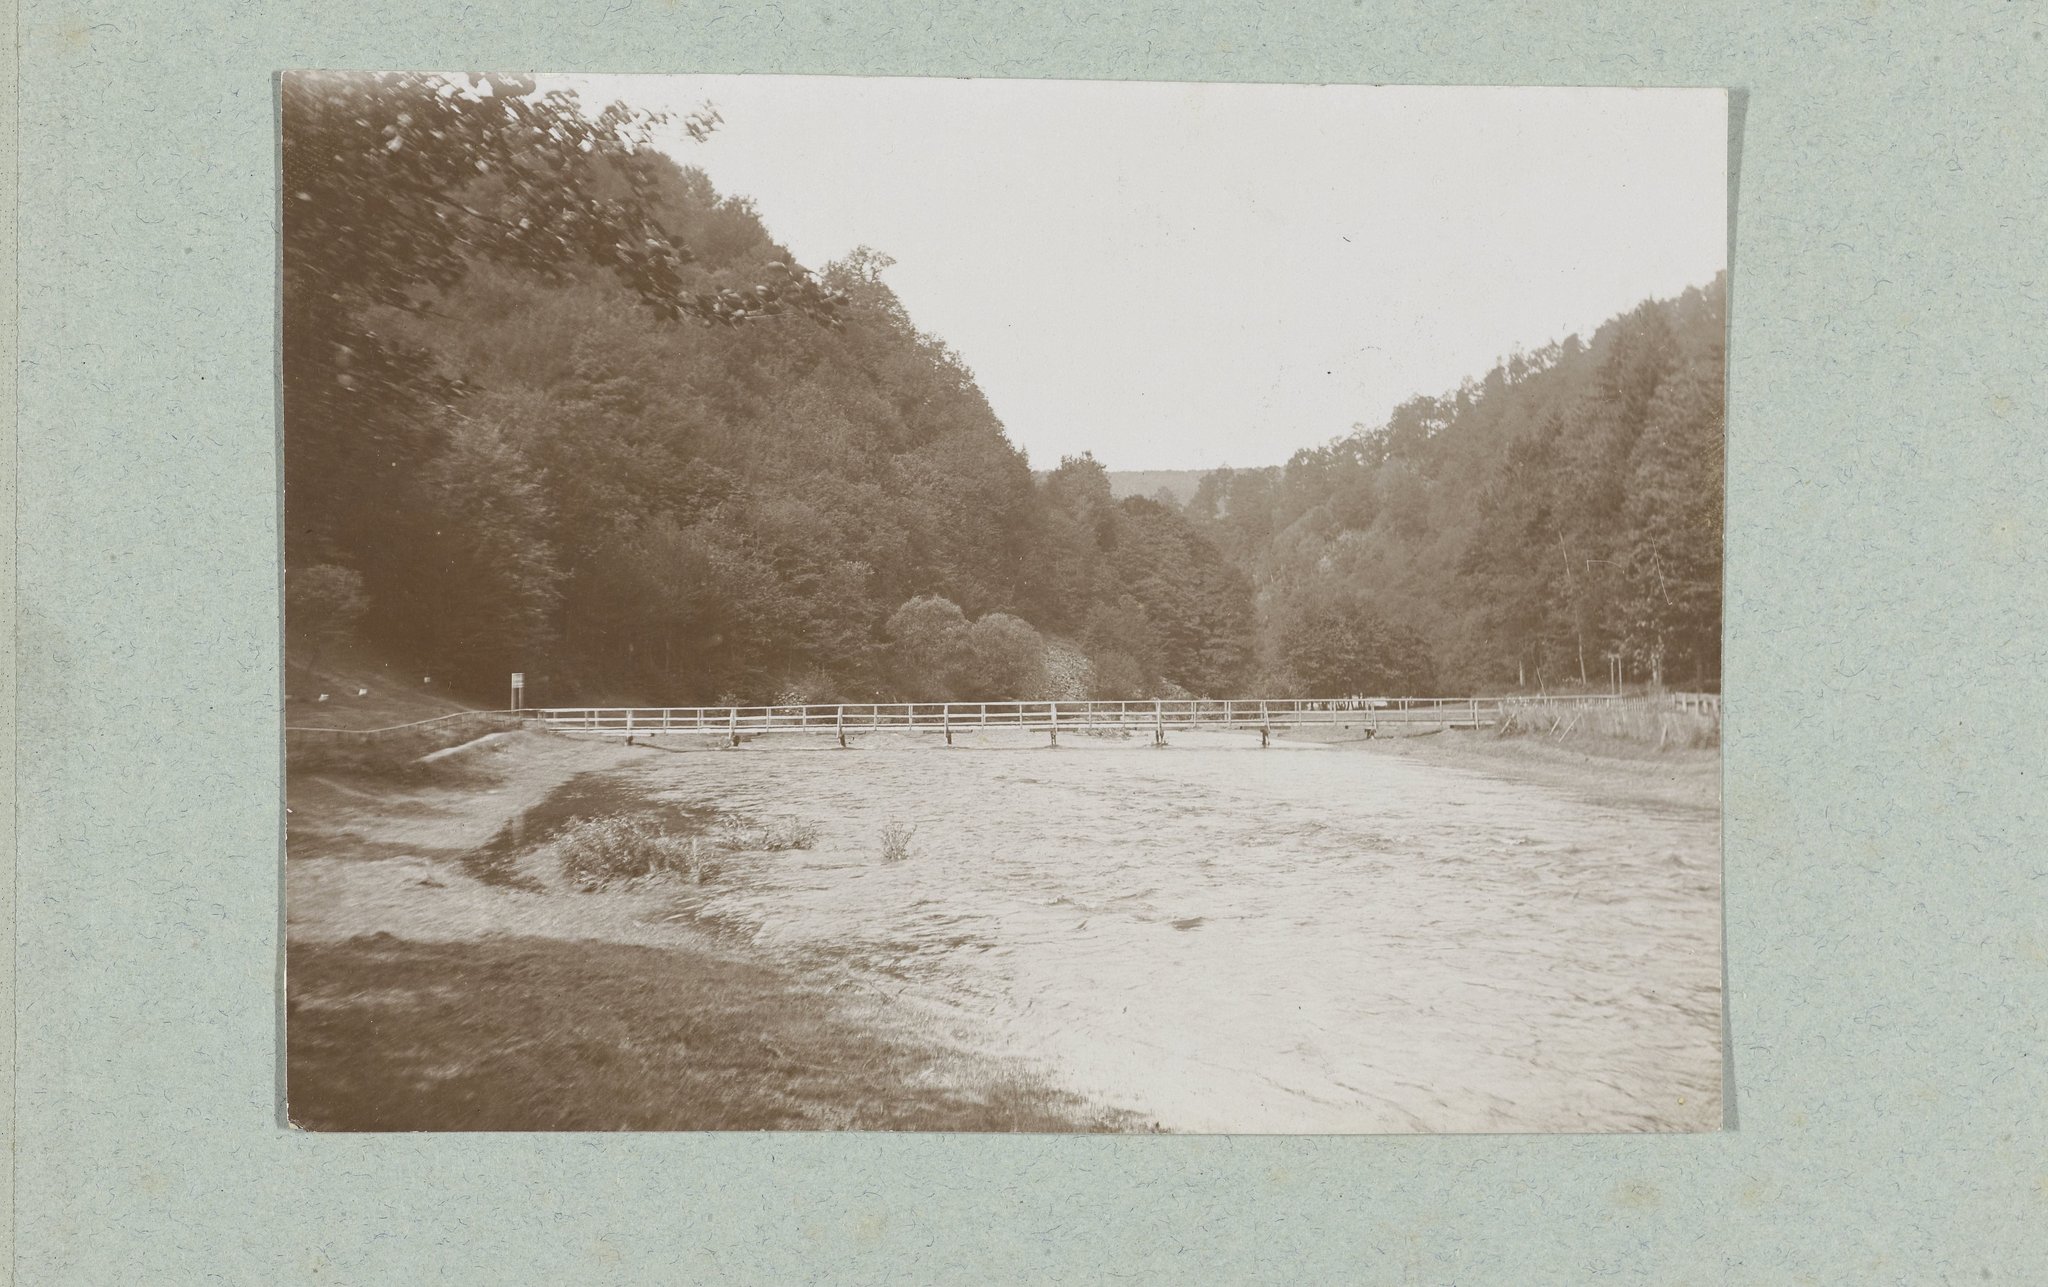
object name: photograph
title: Photographieën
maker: frits freerks fontein fz.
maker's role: fotograaf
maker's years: 1882-1928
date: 1903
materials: cardboard, paper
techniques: gelatin silver print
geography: netherlands